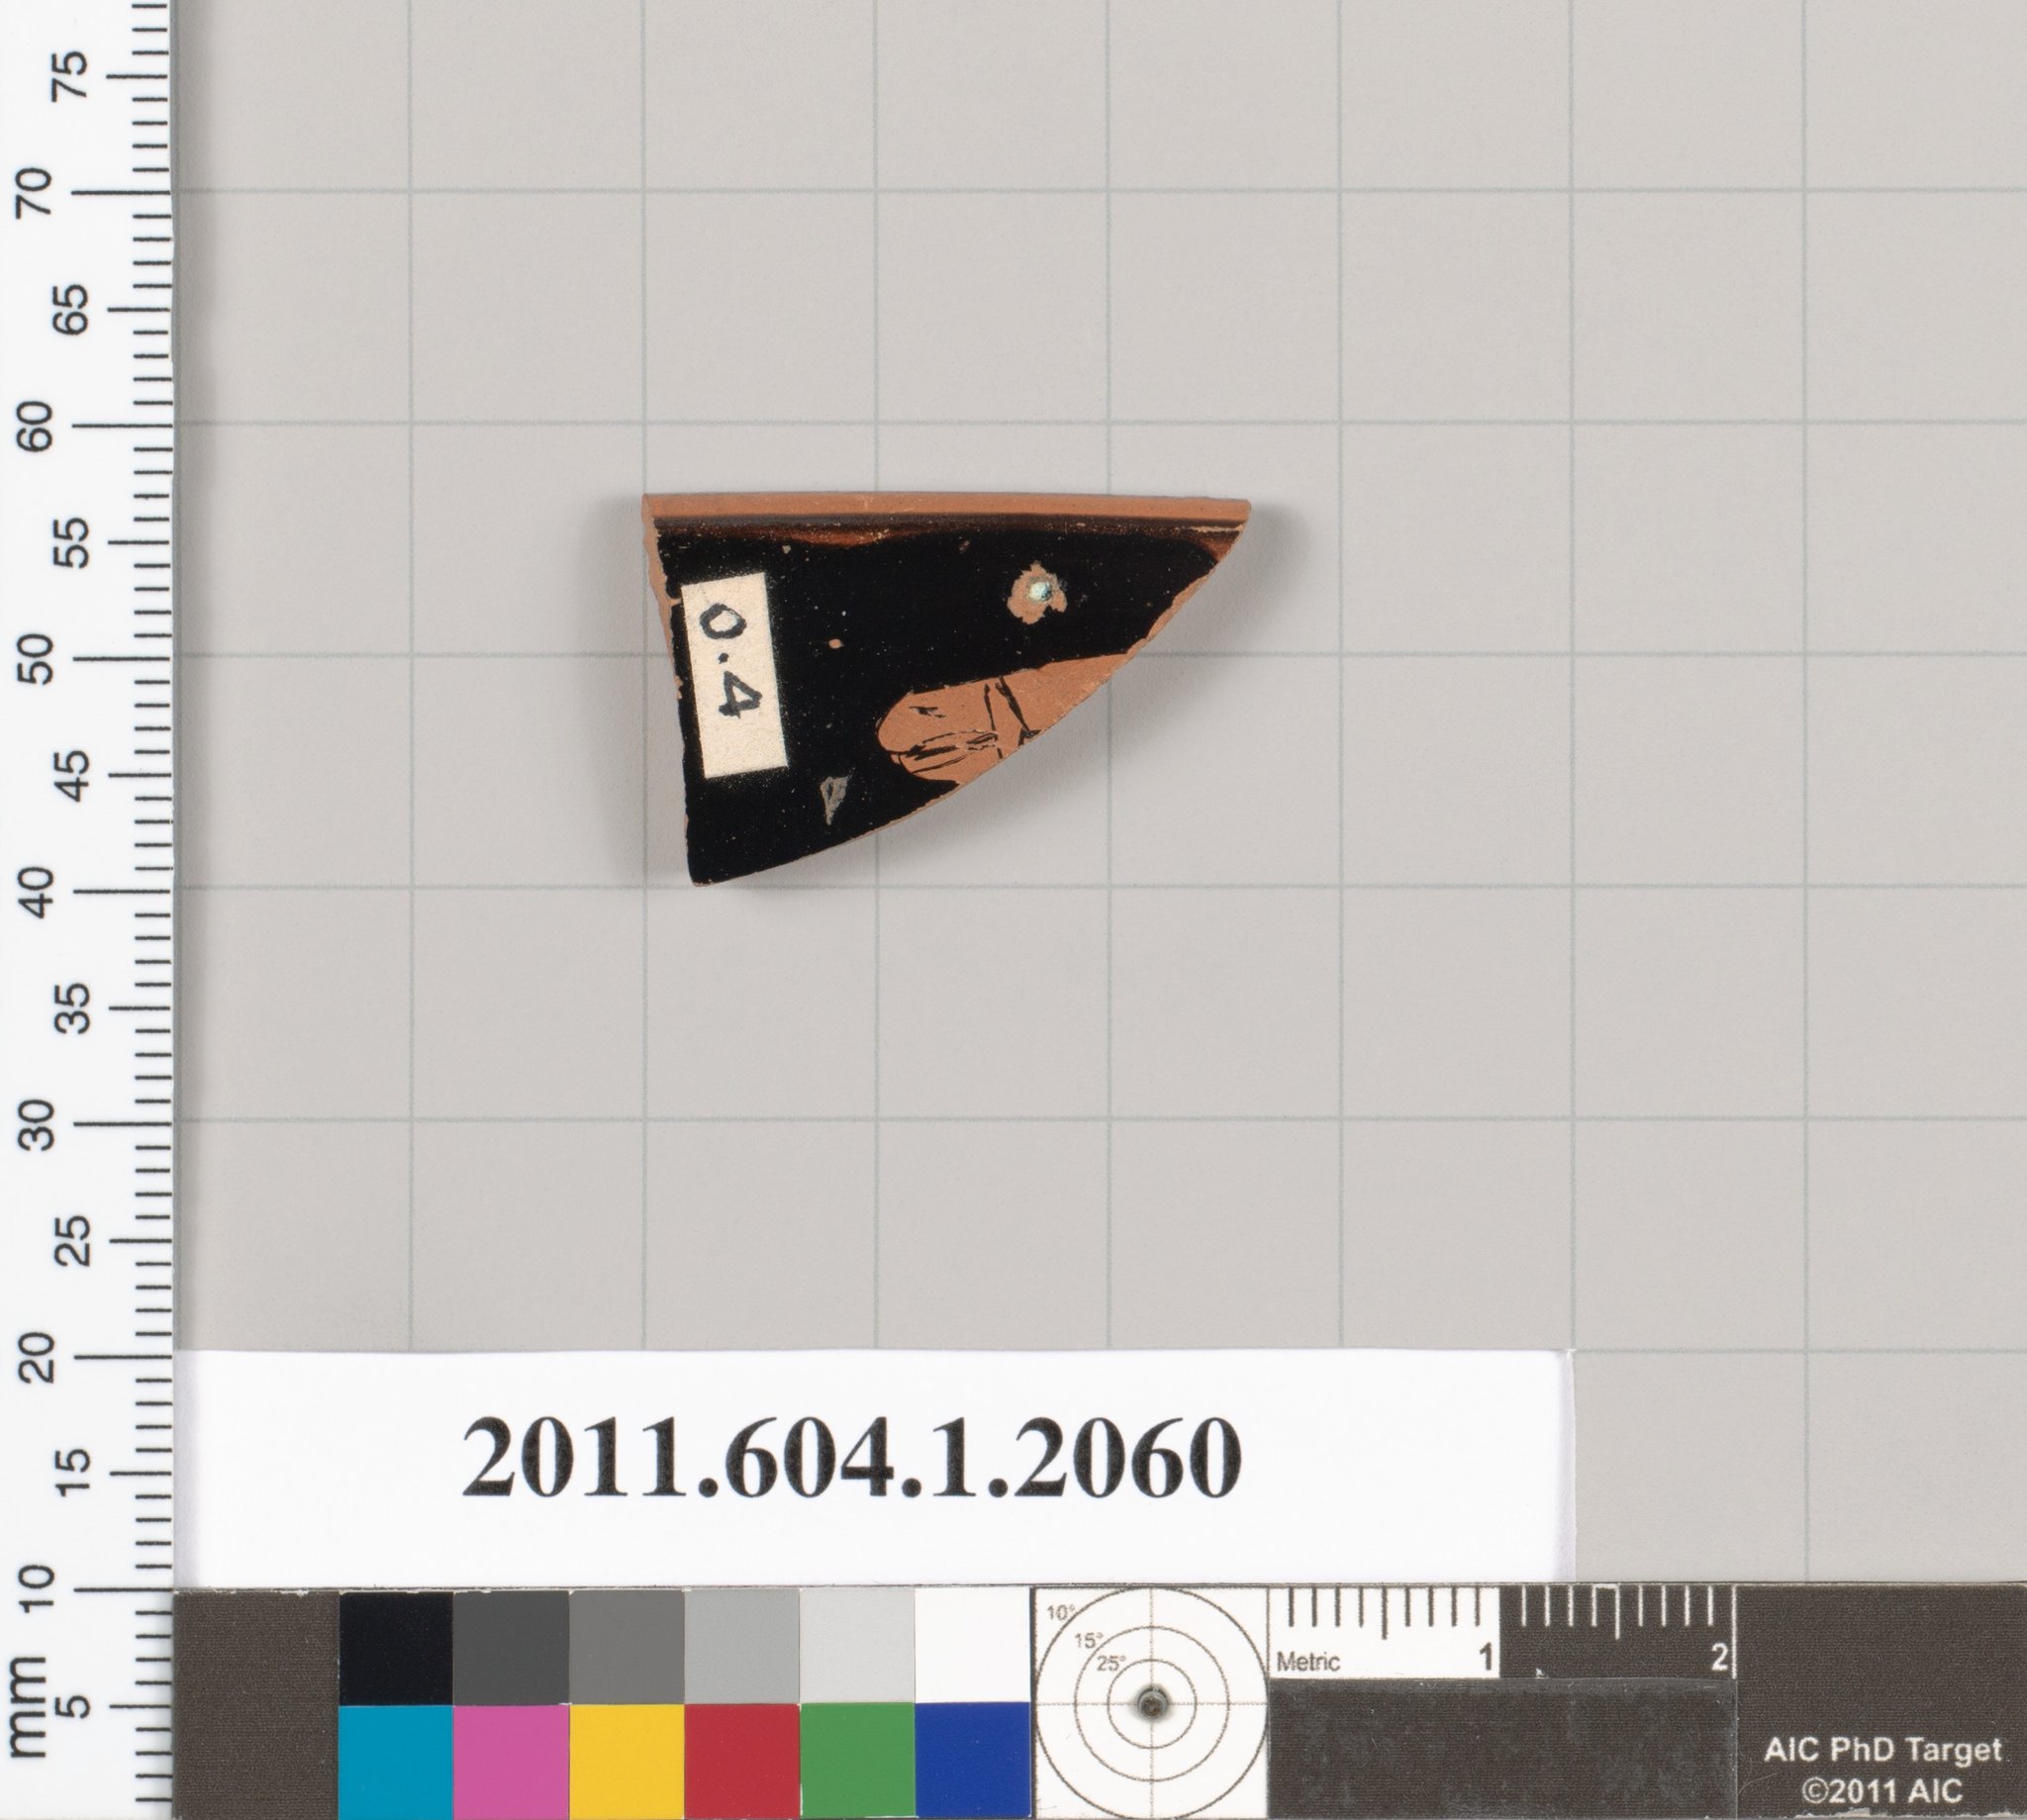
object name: kylix fragment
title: Terracotta rim fragment of a kylix (drinking cup)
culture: greek, attic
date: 475-451 BCE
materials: terracotta